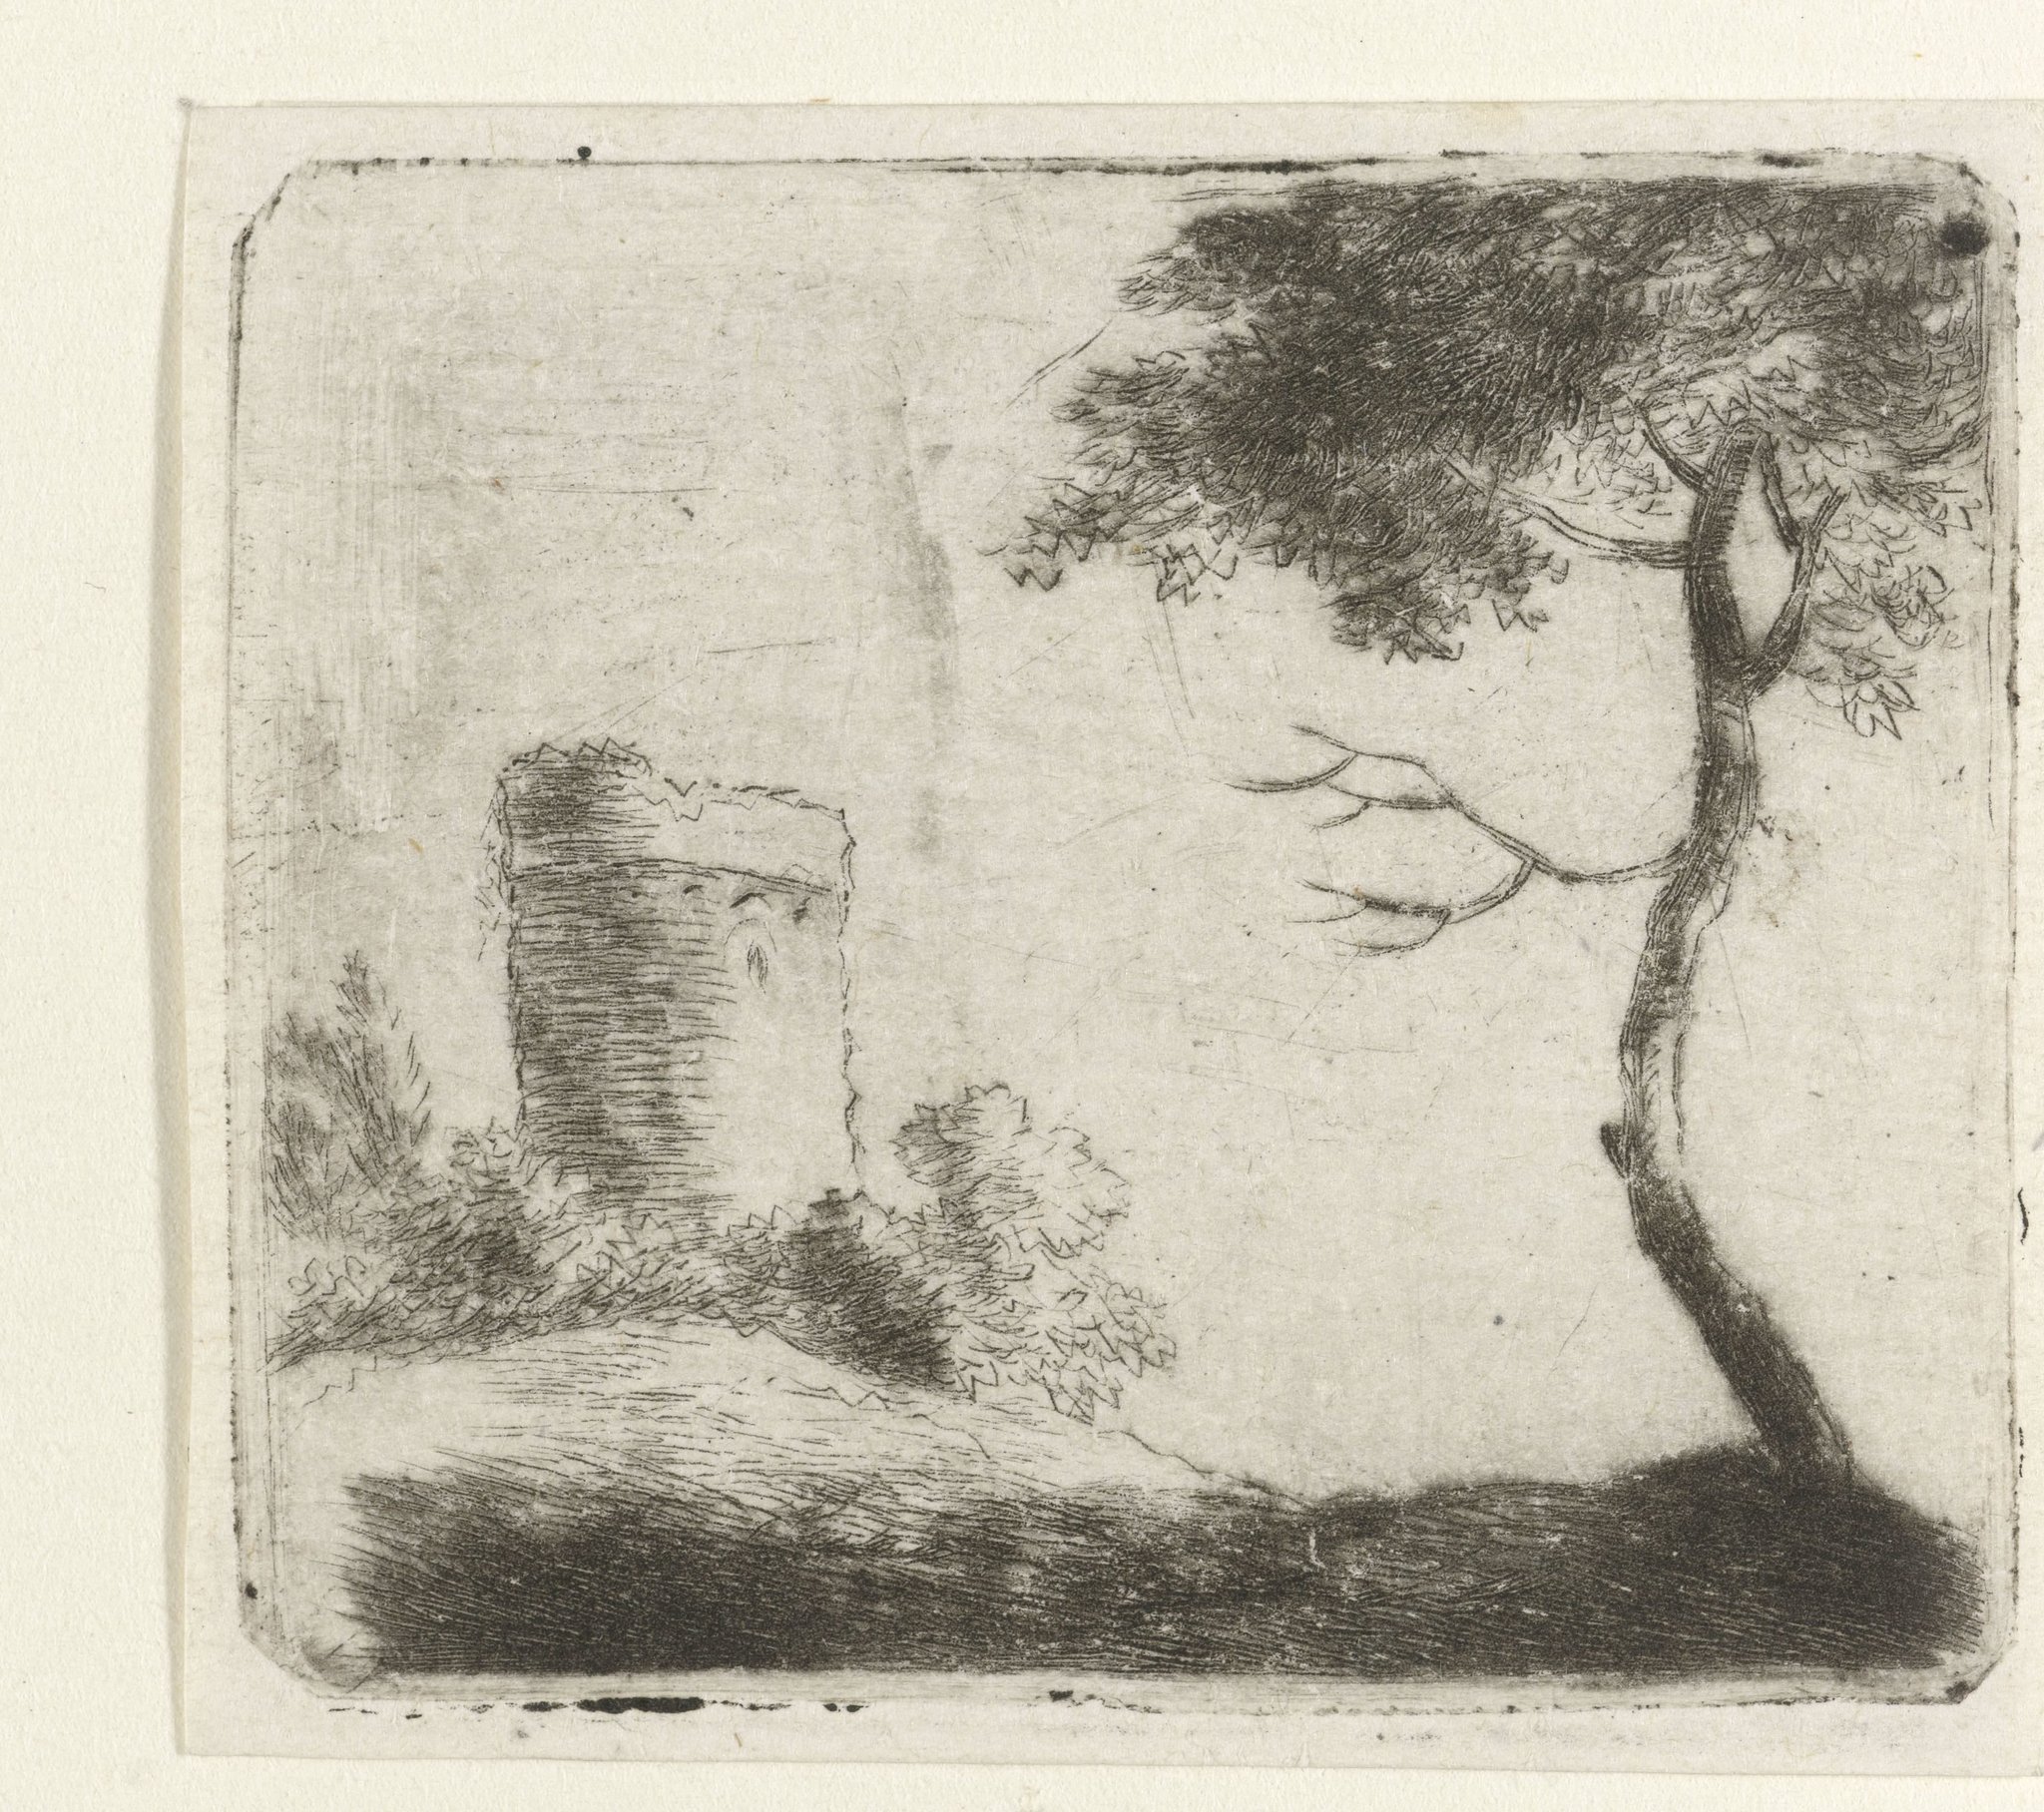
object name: print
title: Landschap met ronde toren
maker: johannes janson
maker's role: draughtsman, painter, print maker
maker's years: 1729-1784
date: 1761-1784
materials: paper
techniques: etching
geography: leiden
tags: landscape with tower or castle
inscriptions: collector's mark: Lugt 2228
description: Landschap met ronde toren en rechts op de voorgrond een boom.